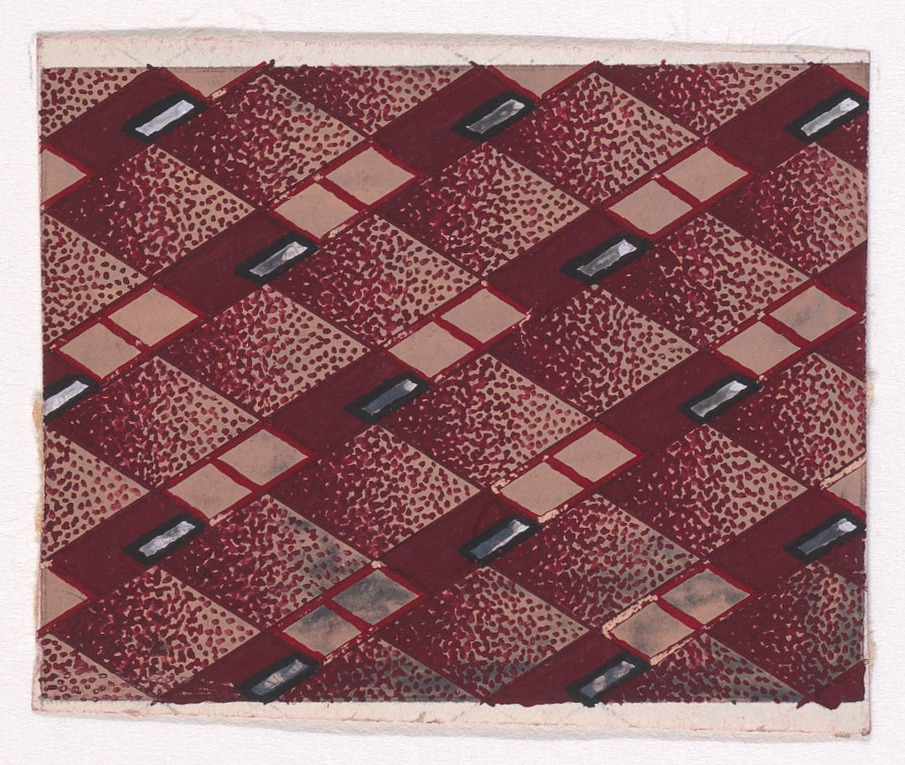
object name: drawing ornament architecture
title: Textile Design with Alternating Horizontal Seamless Strips of Lozenges and Stripes Decorated with Lozenges and Small Decorative Motifs that Resemble a Baguette-Cut Diamond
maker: anonymous, alsatian, 19th century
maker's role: artist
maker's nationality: alsatian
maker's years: 1800-1900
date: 1840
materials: gouache